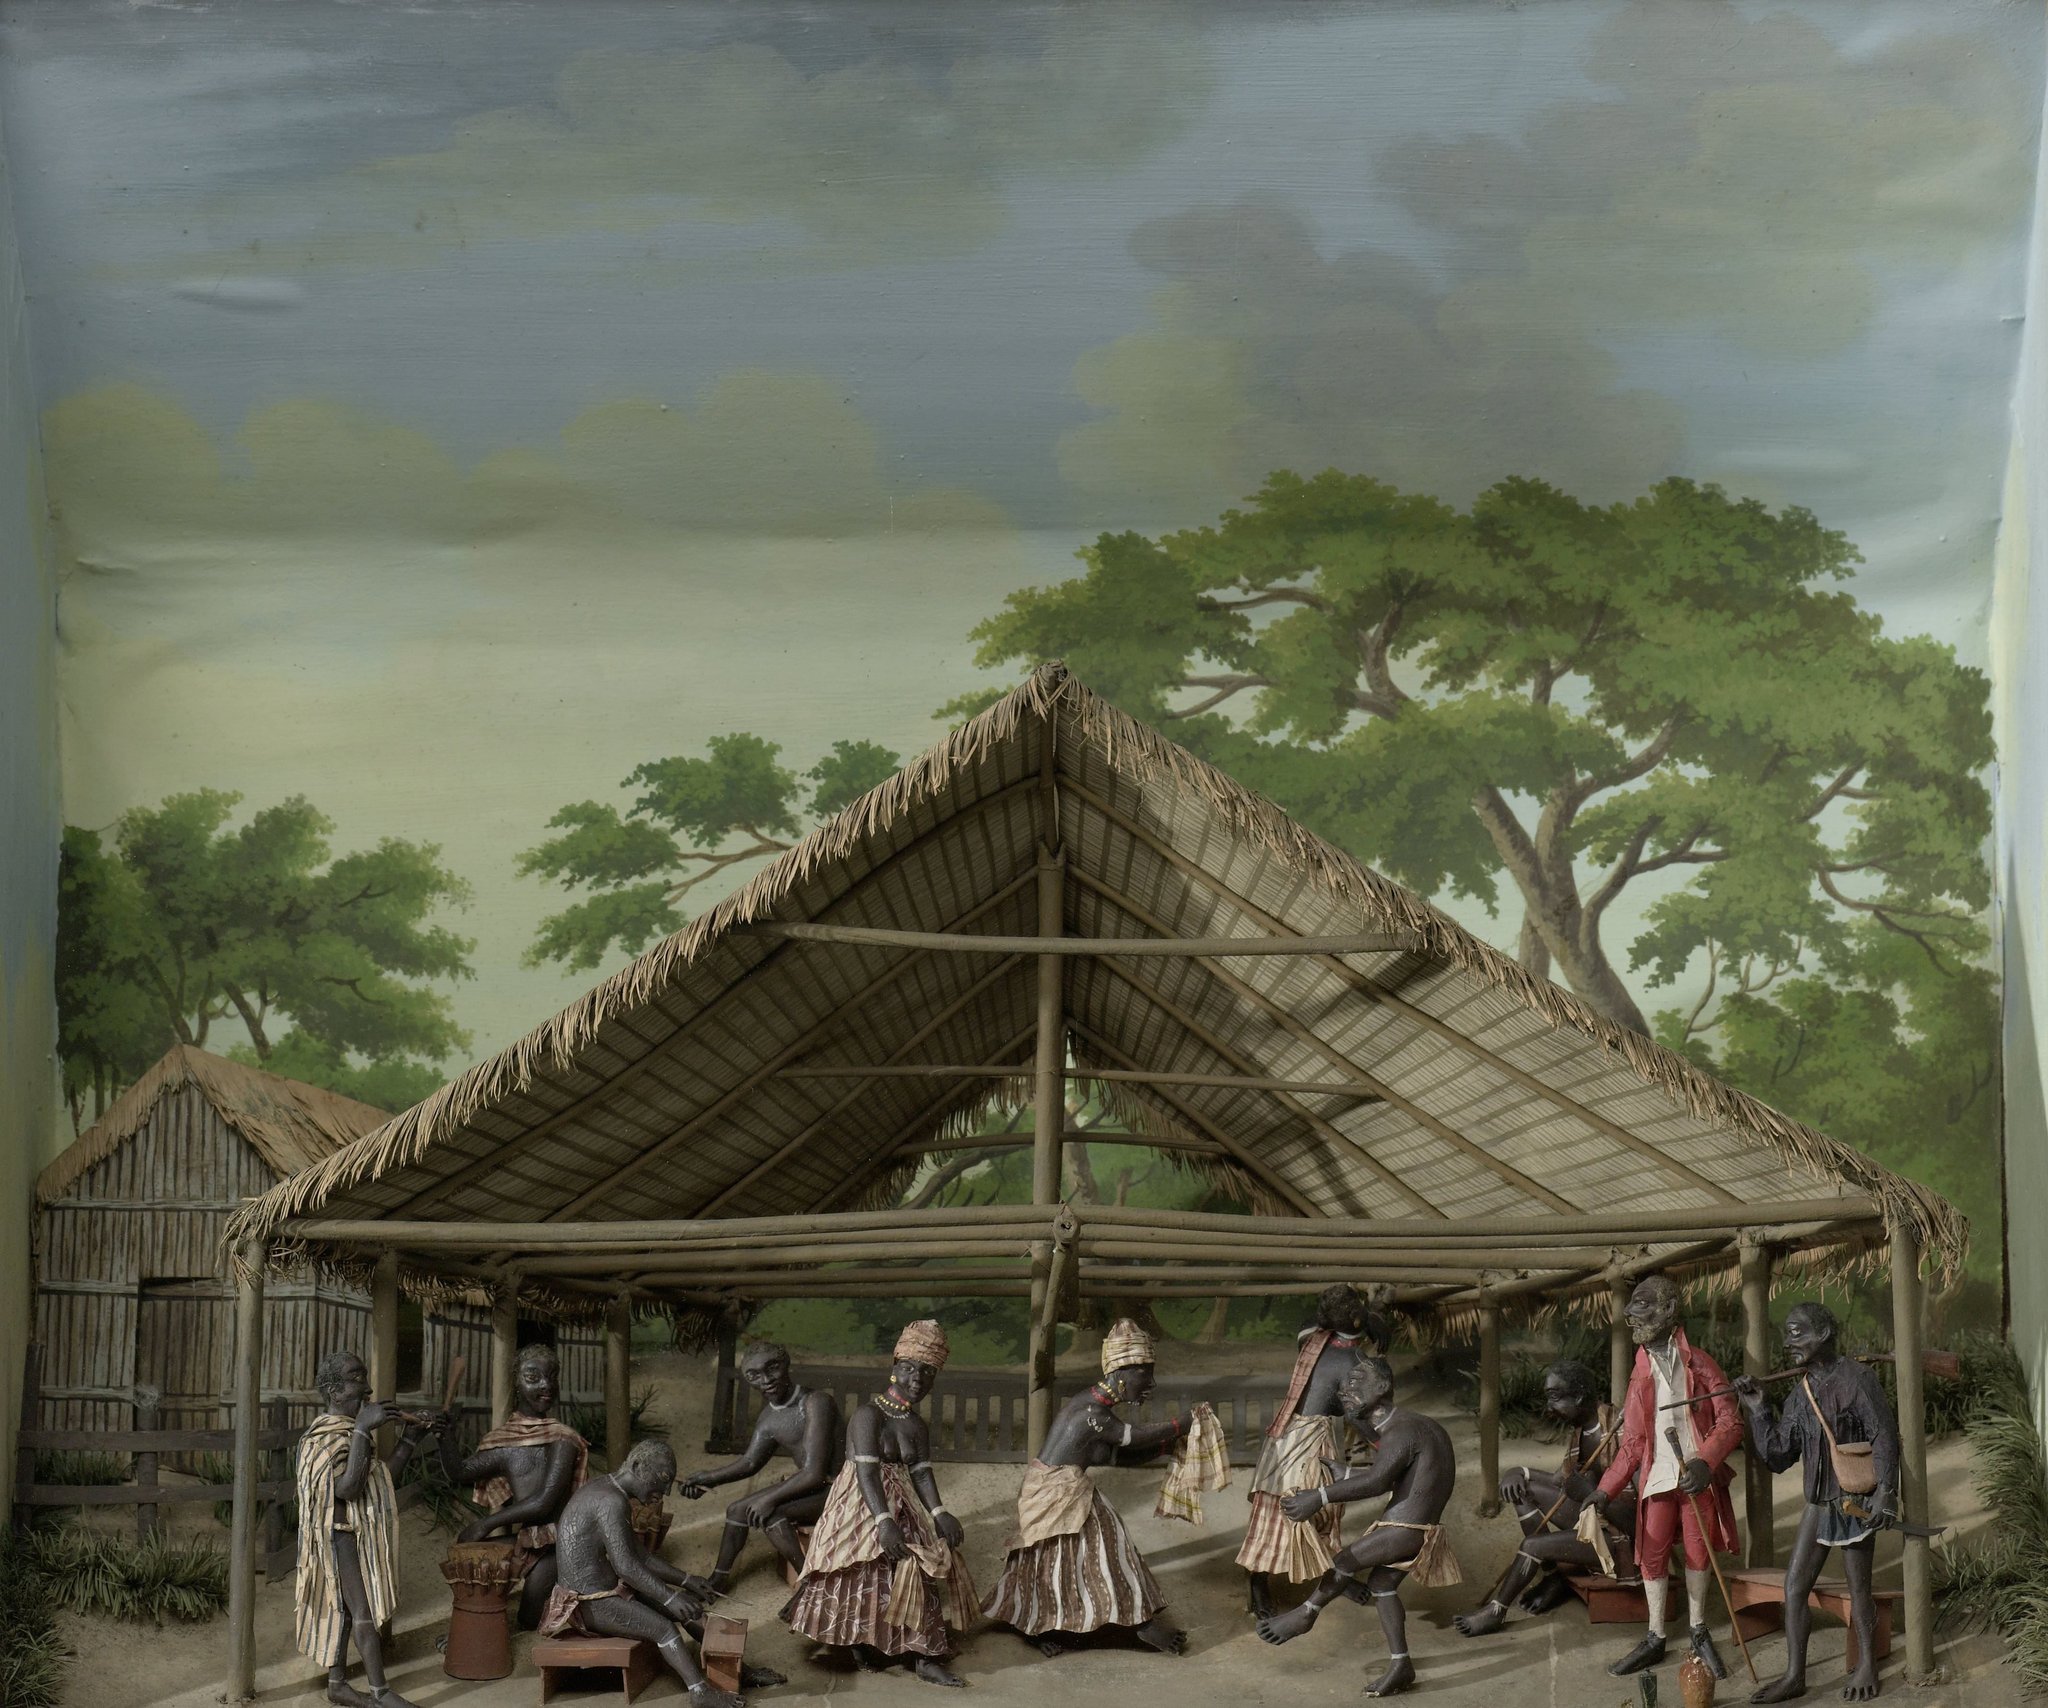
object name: diorama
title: Diorama of a Du, Dance Celebration on the Plantation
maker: gerrit schouten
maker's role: draughtsman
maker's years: 1779-1839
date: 1830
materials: paper, wood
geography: suriname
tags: hunter, slavery; serfs and enslaved persons, group dancing, more than one musician with instrument, suriname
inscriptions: signature and date: ‘G. Schoüten fecit 1830’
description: In progress in the dance tent is a du, a type of role-play with music and dance that was held on the plantations. Both the performers and the spectators were people held in slavery. The lead role was reserved for the afrankeri, the narrator (the woman on the far left). The man in the red suit on the right portrays the colonial authority. During the annual du, enslaved people could give vent to their criticism of this authority or organize resistance in their own language, Sranan Tongo.